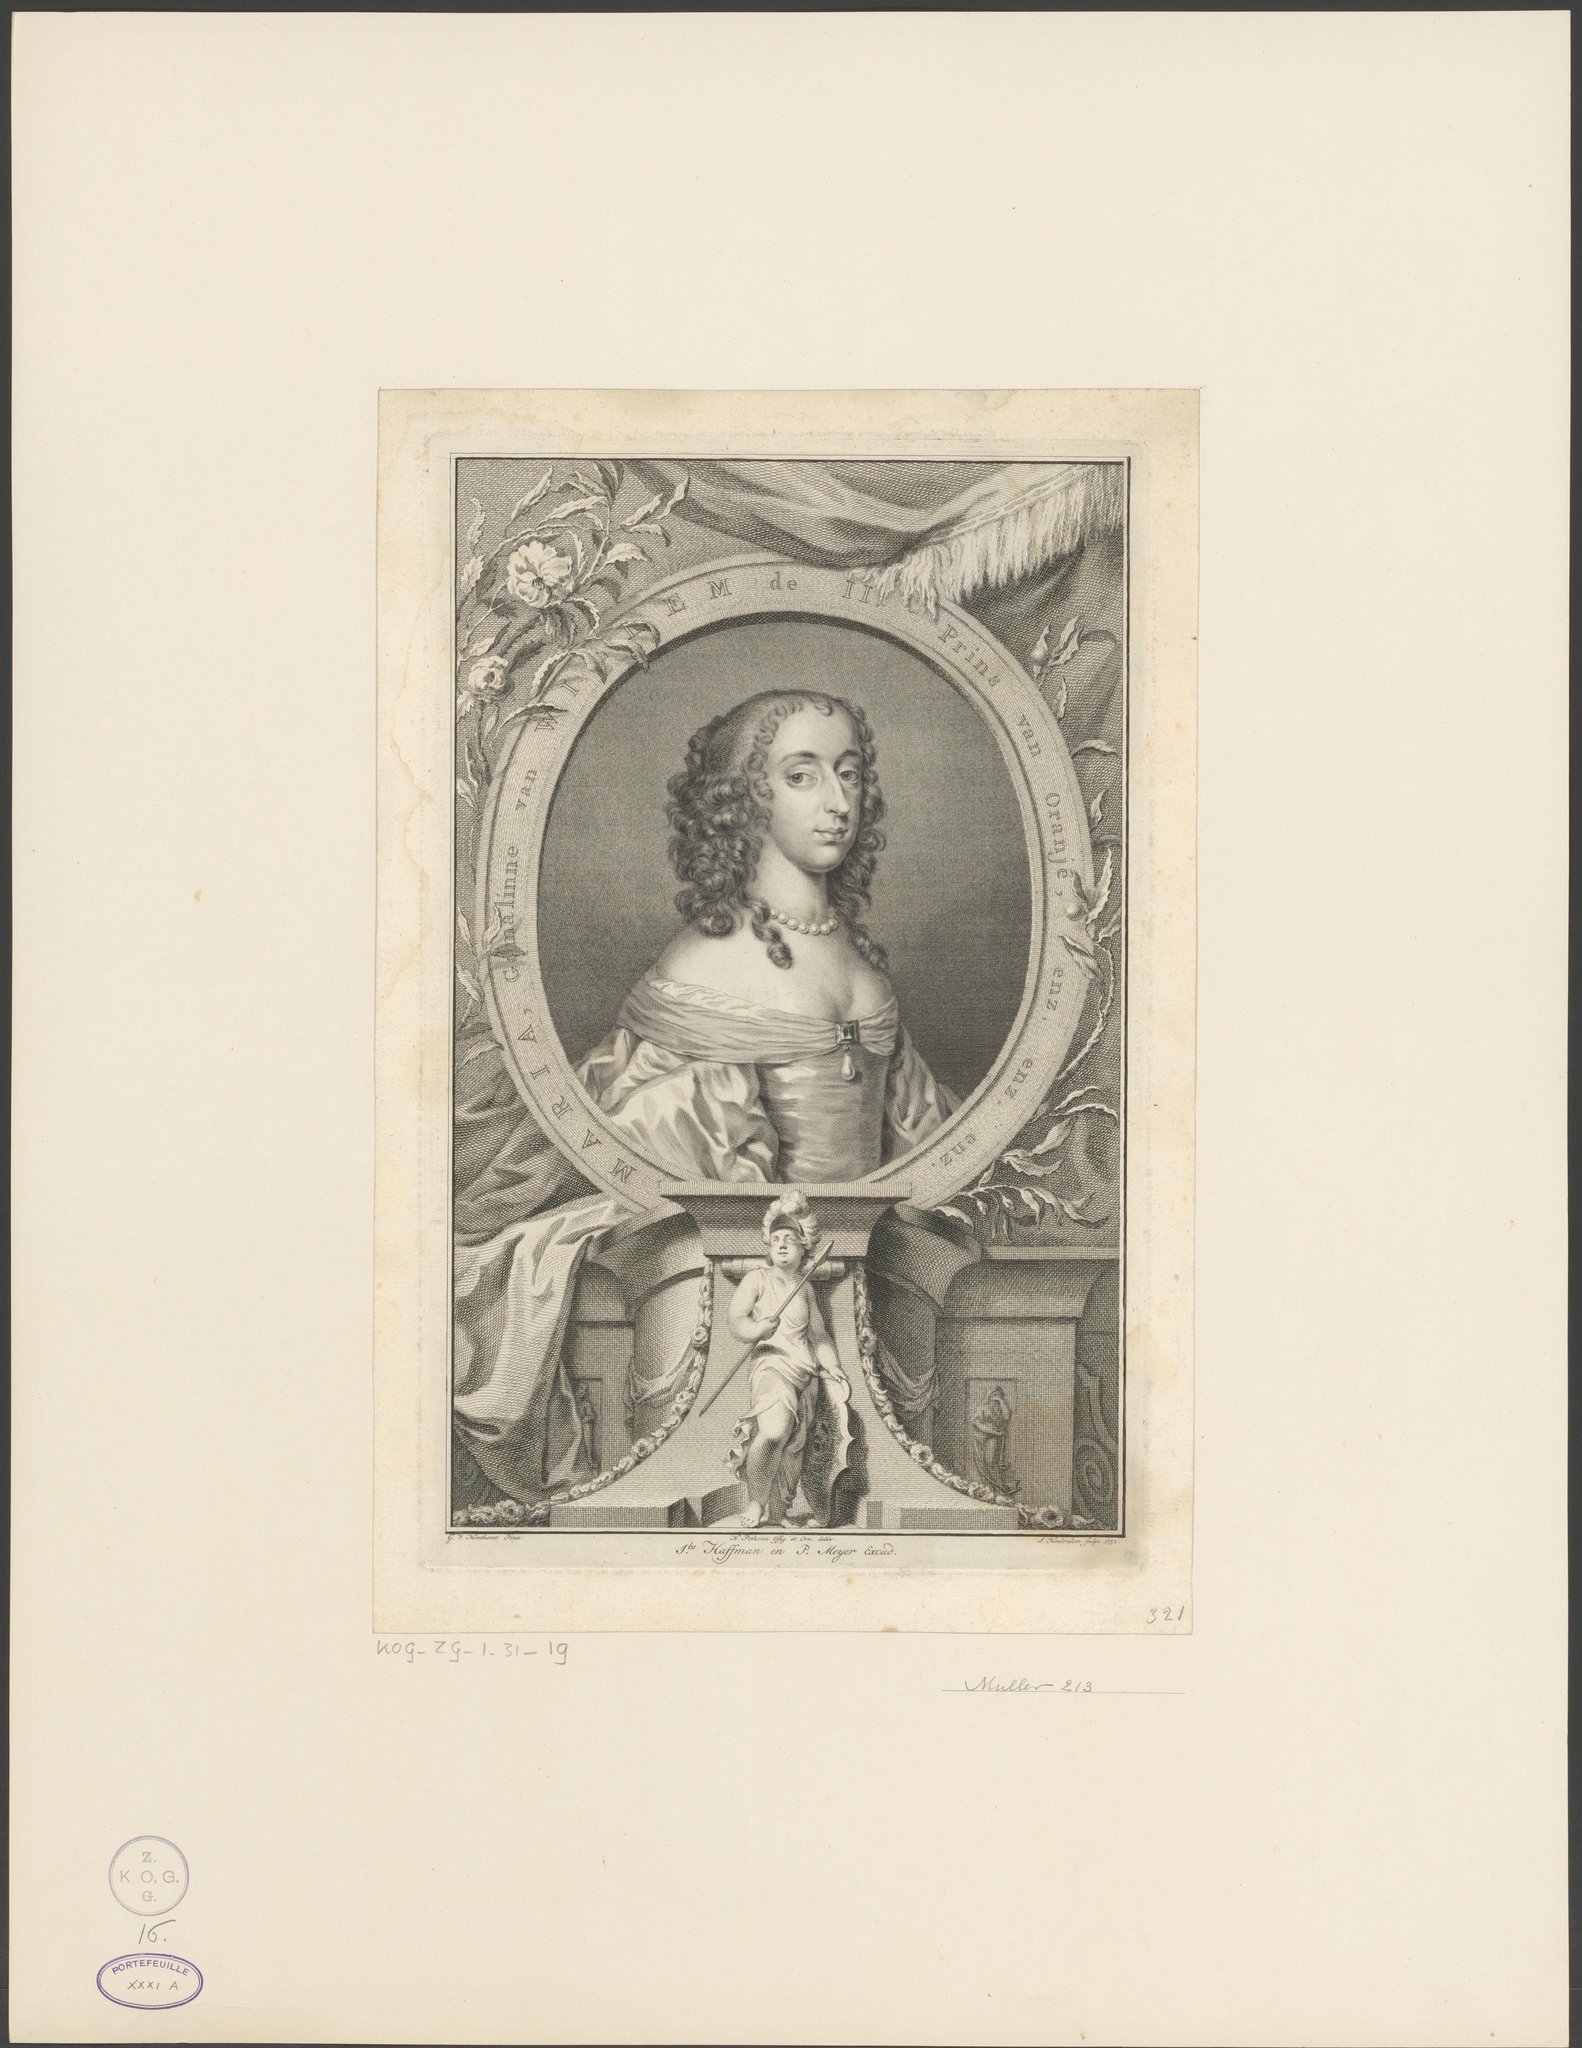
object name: print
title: Portret van Maria Henrietta Stuart, prinses van Oranje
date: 1752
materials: paper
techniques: engraving, etching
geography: amsterdam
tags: london, mary henrietta stuart, historical persons - bb - woman, cupids: 'amores', 'amoretti', 'putti'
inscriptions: collector's mark: Lugt 1641, stamp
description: Portret van Maria Henrietta Stuart, prinses van Oranje, echtgenote van prins Willem II van Oranje-Nassau. Derde prent uit een serie van zes met de afbeeldingen van de gemalinnen en moeders van de stadhouders. Onderwerpsrubrieken binnen de Atlas Zeden en Gewoonten: Portretten, Portretten van Vorsten uit het huis van Oranje, Regeerende Vorsten, Stadhouders van Holland, Zeeland en West-Friesland.